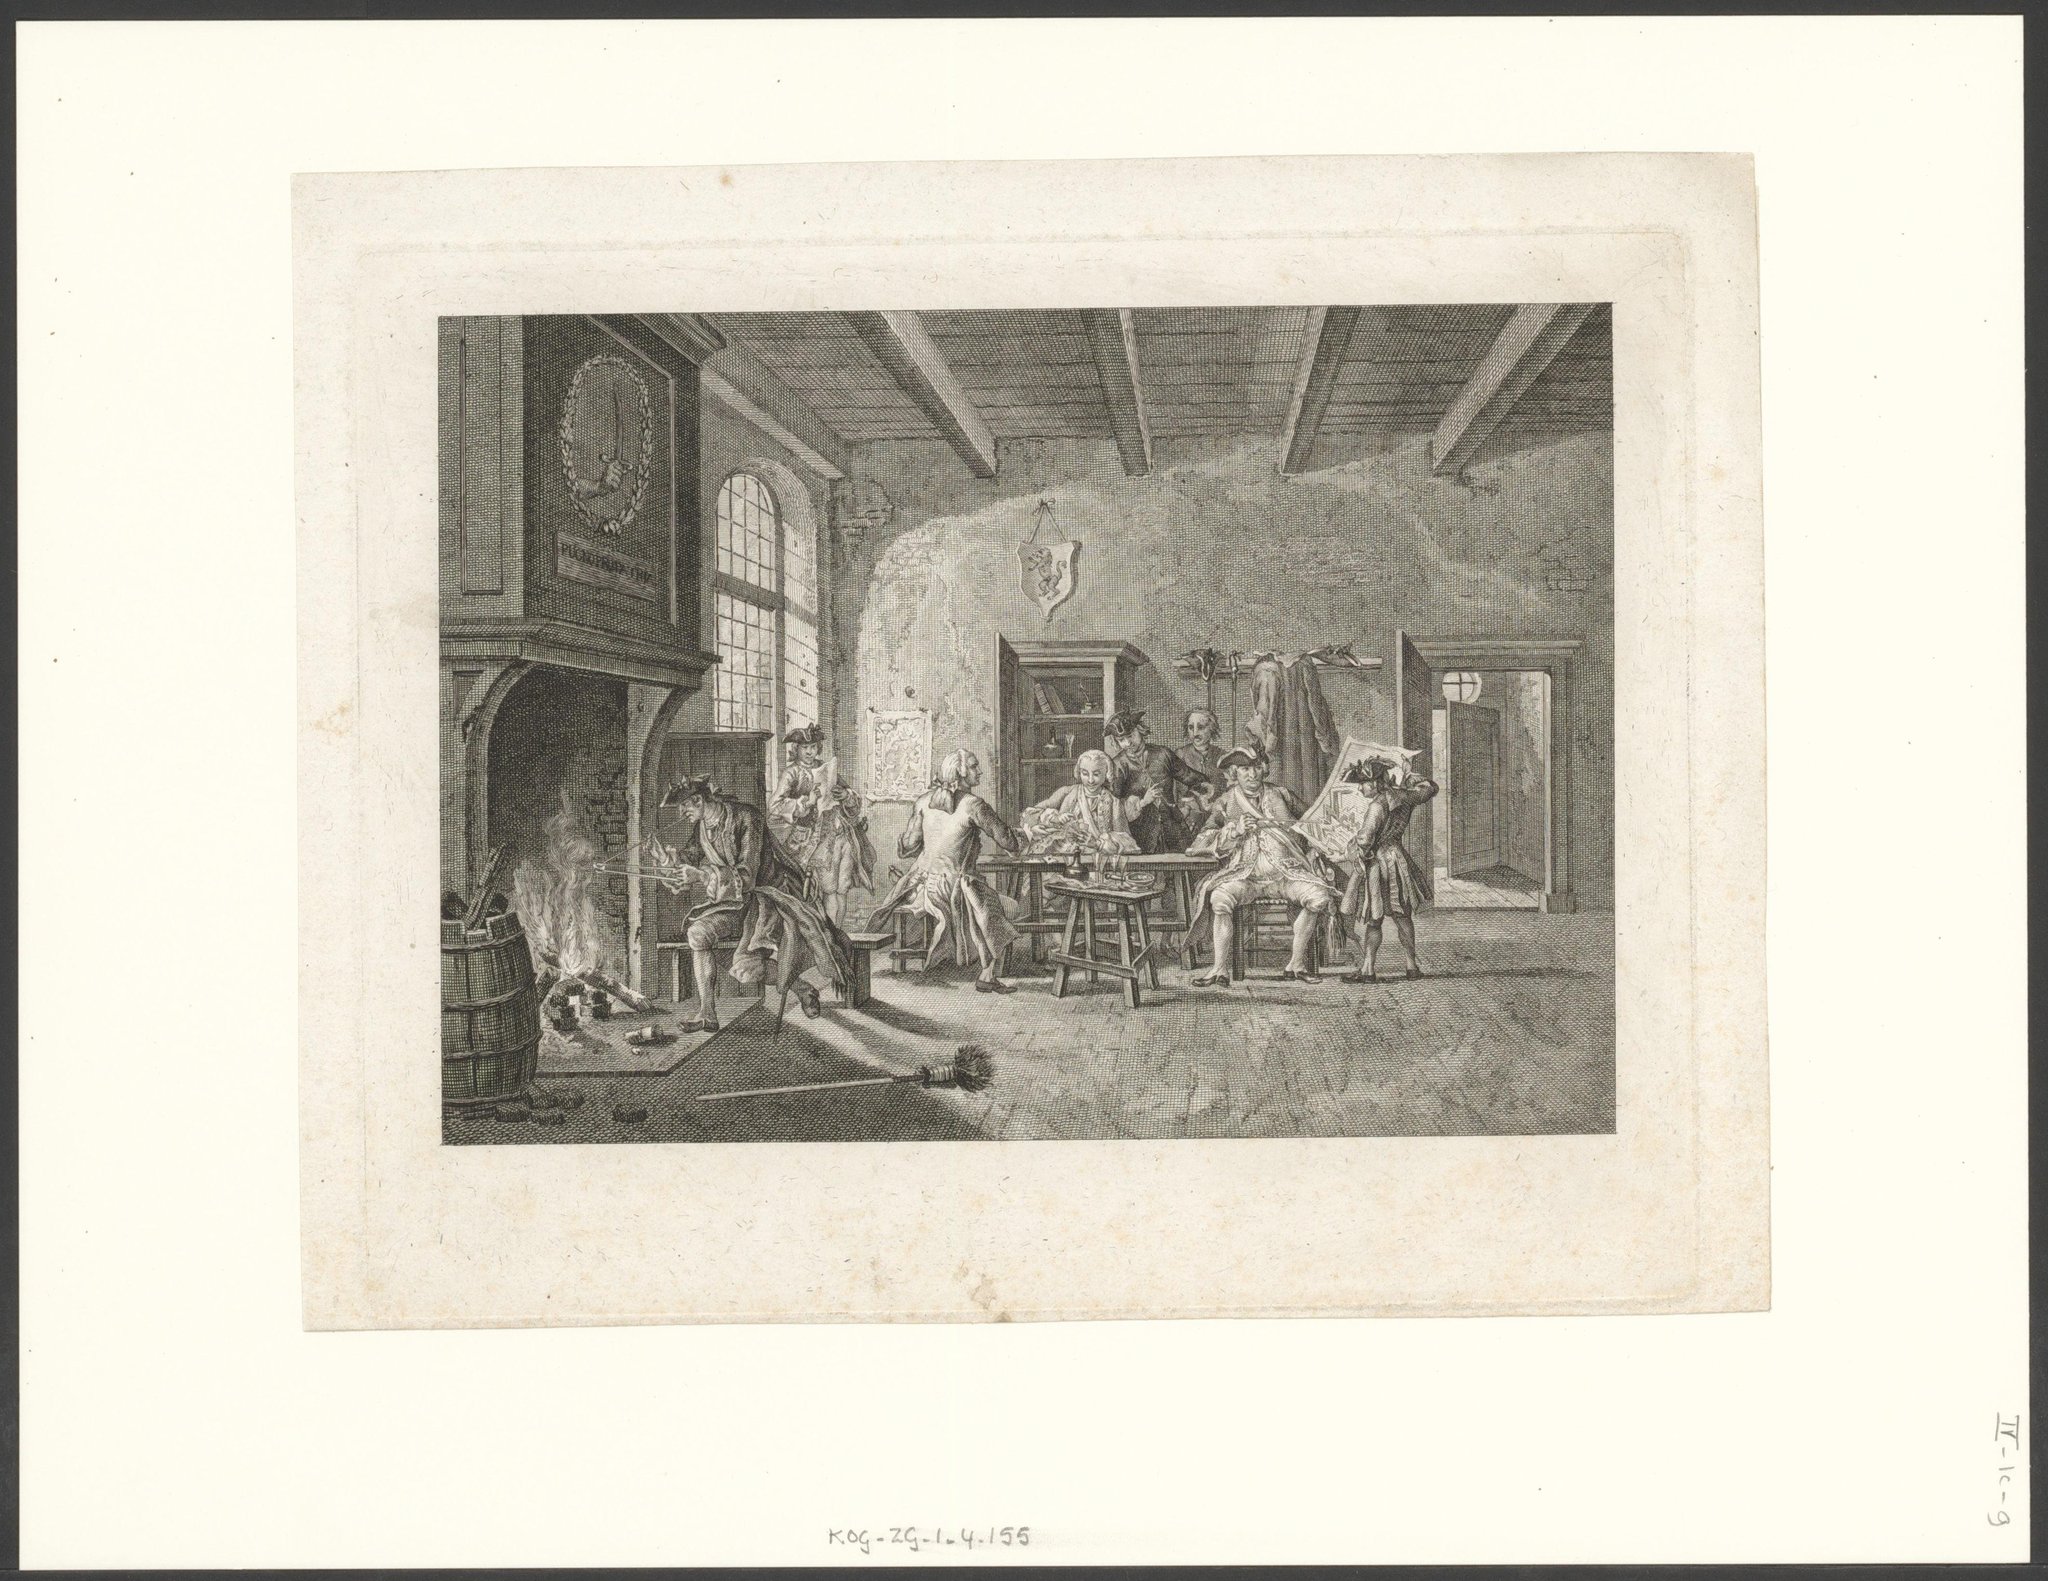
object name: print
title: Corps de Garde van Hollandse Officiers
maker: Anonymous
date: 1750-1799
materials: paper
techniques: engraving, etching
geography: netherlands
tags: in the guard-room, 'kortegaard', studying a map